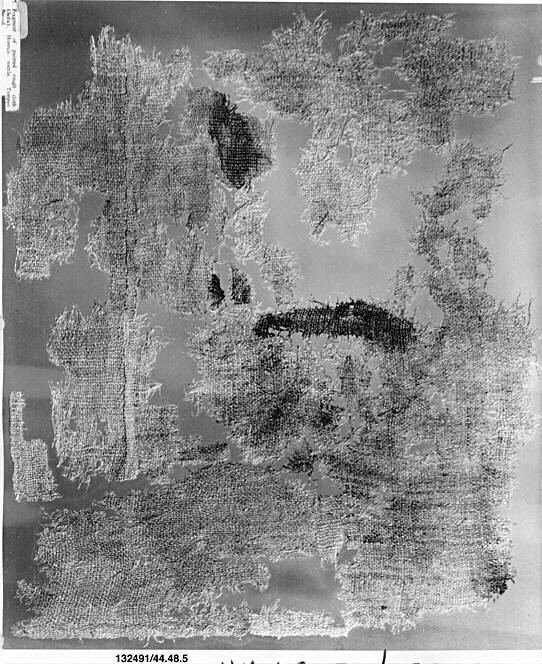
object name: fragment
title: Fragments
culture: japanese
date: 701-800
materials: cotton, linen